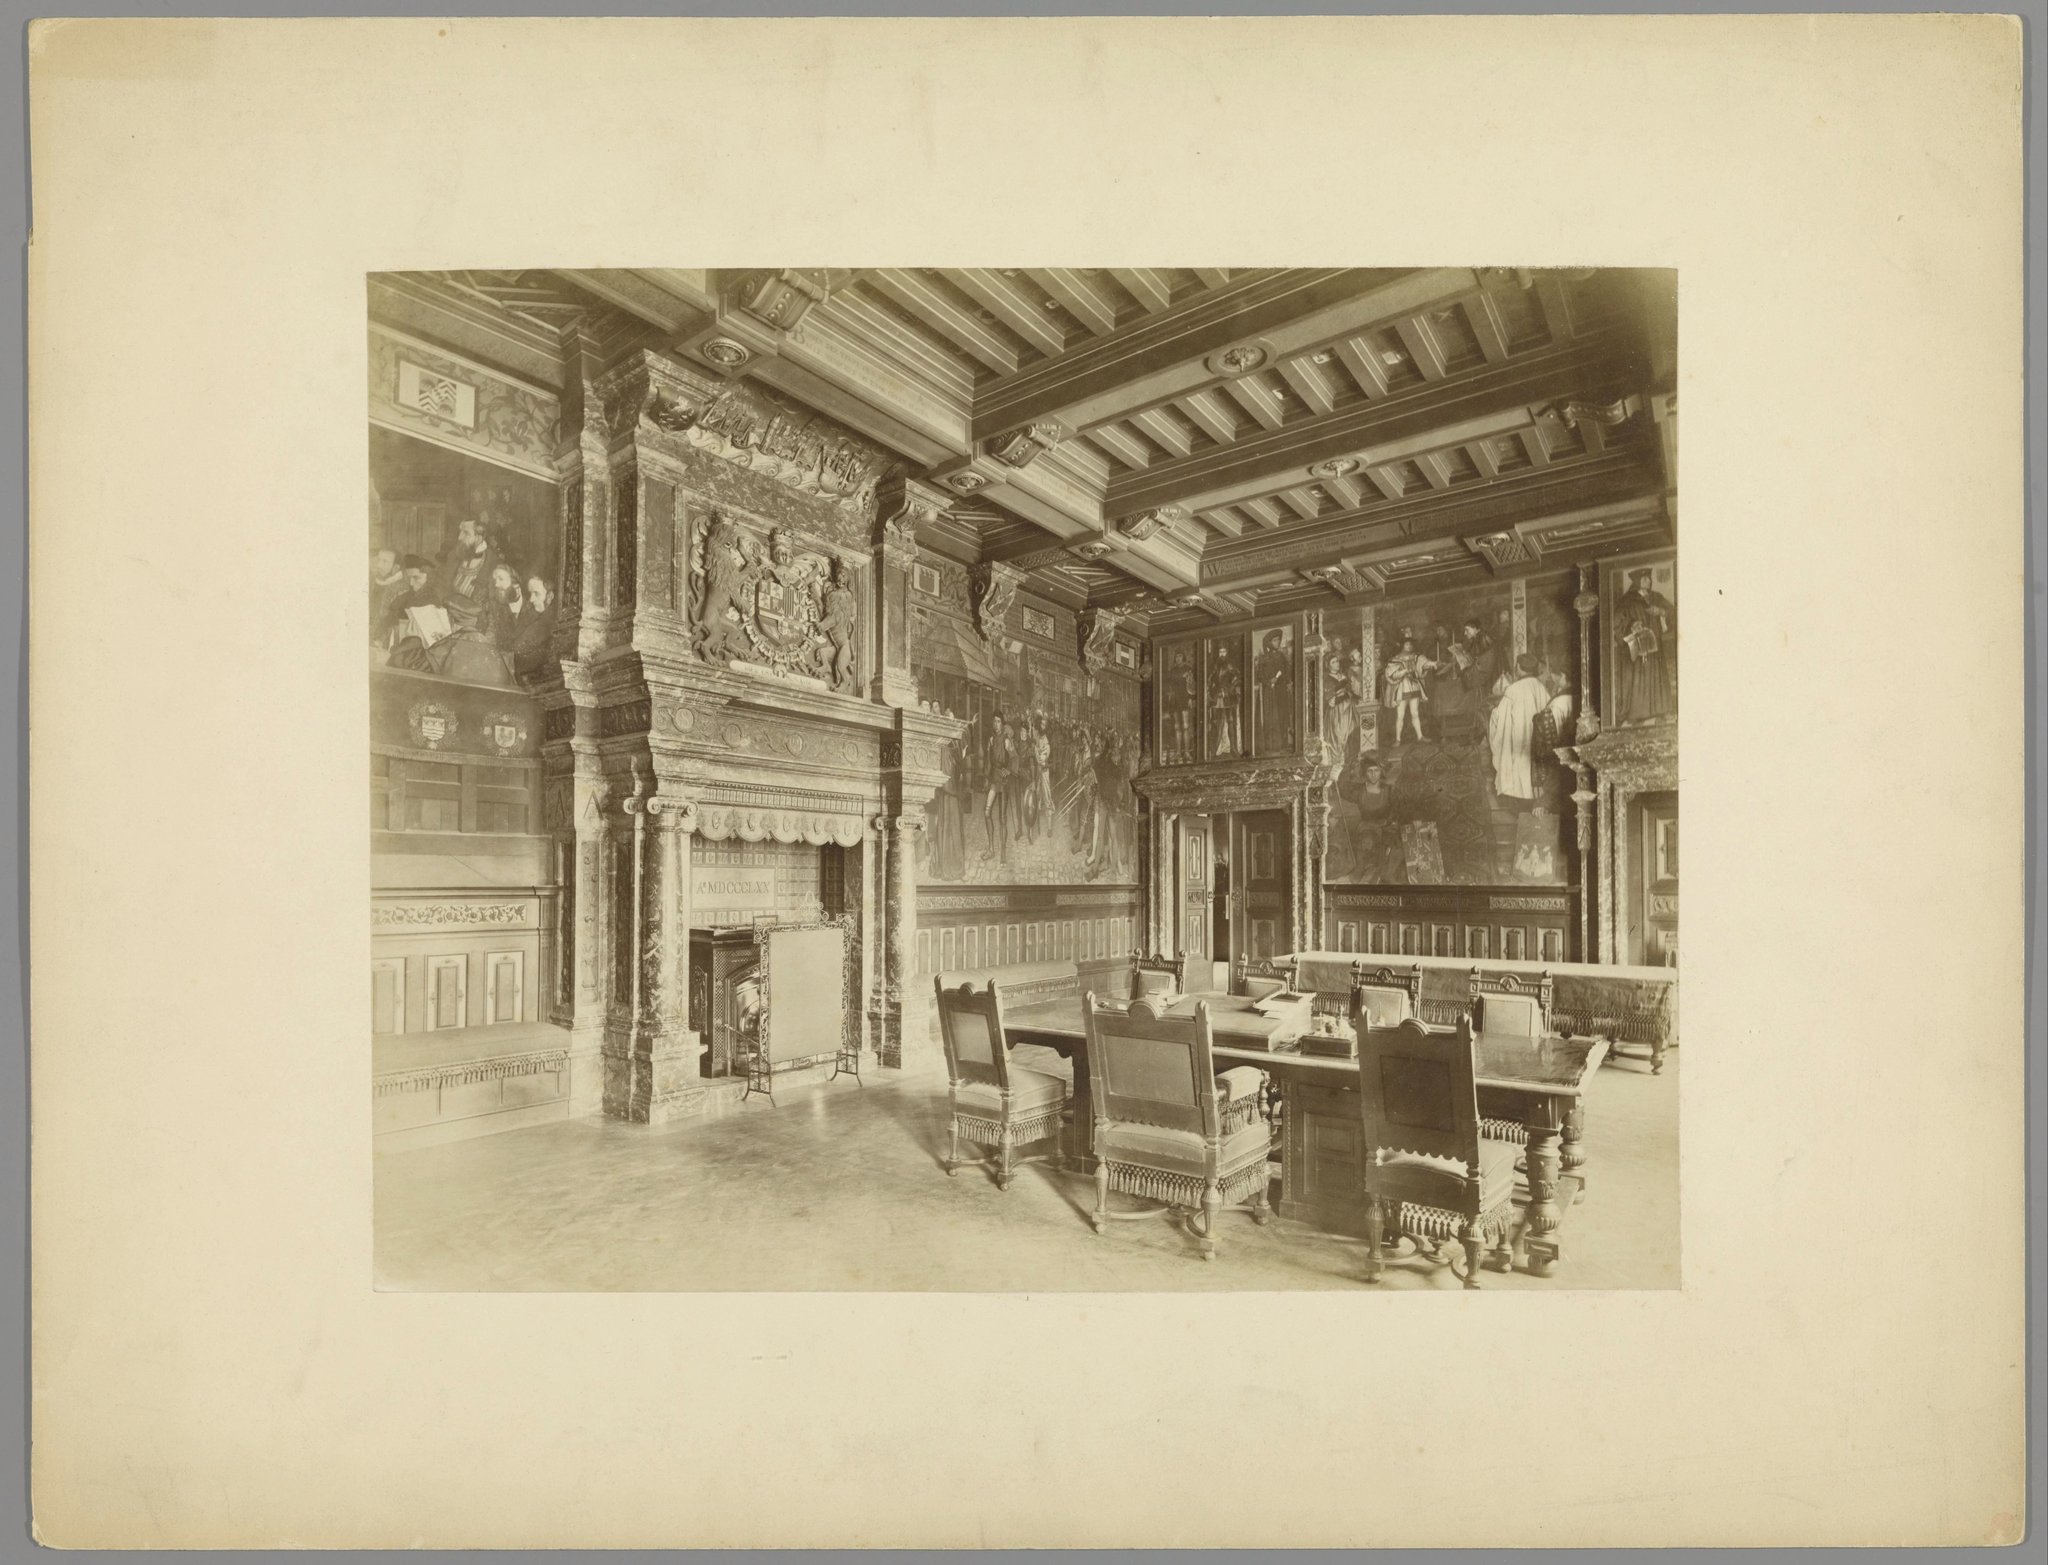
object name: photograph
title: Leyszaal in het stadhuis te Antwerpen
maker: Anonymous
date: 1875-1900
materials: cardboard, photographic support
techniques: albumen print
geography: antwerp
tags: coat of arms (as symbol of the state, etc.), open hearth, fire-place, townhall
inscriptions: number: ‘No 74’